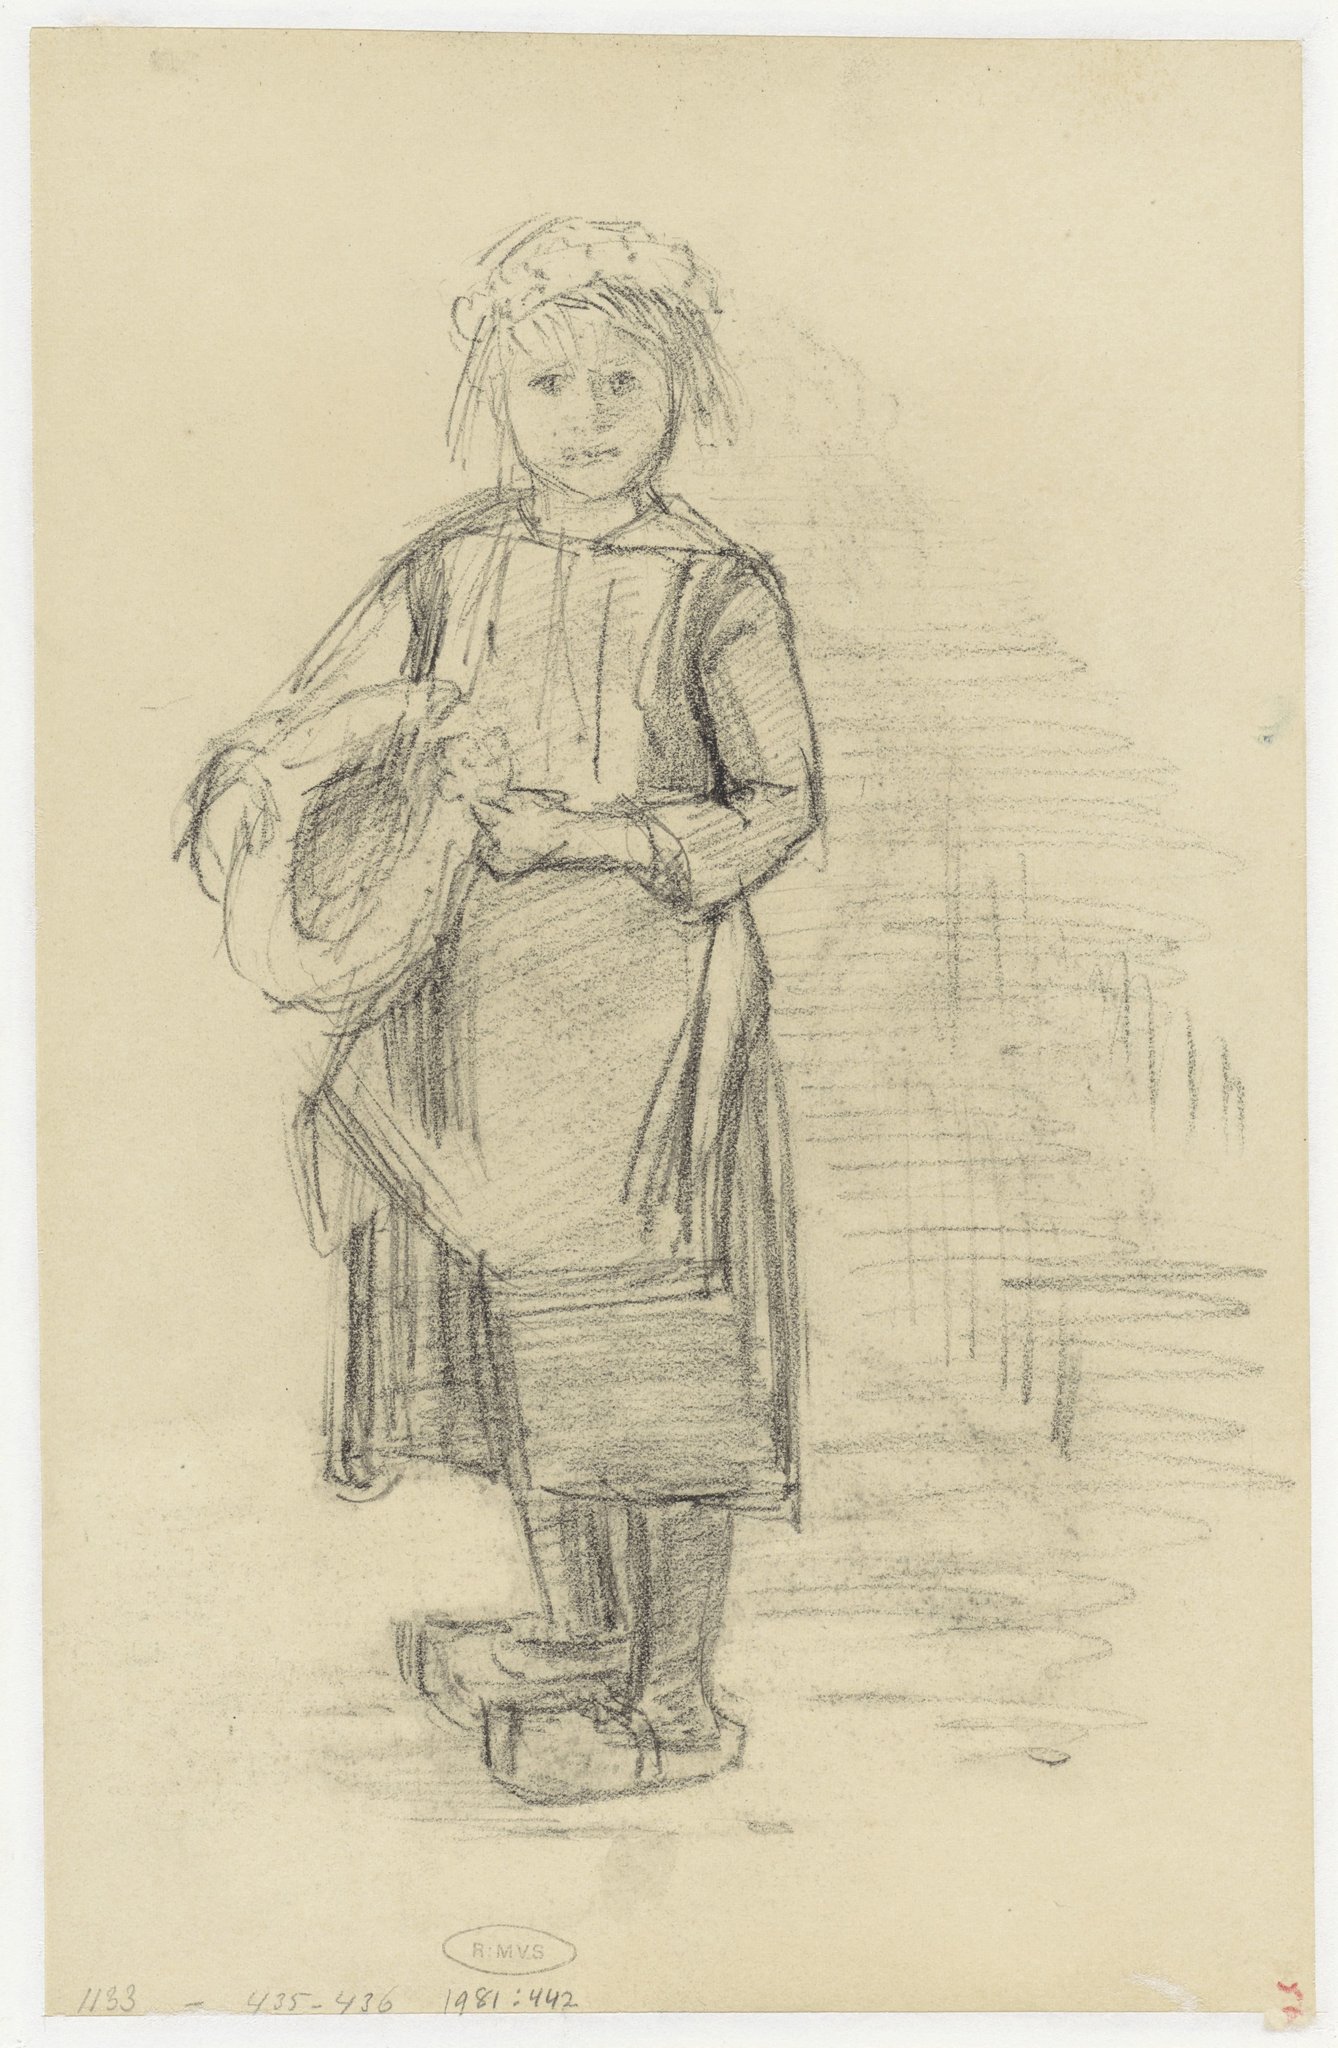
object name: drawing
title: Staand meisje, met een hoed (?)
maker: jozef israëls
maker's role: draughtsman, painter, print maker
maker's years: 1824-1911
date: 1834-1911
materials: chalk, paper